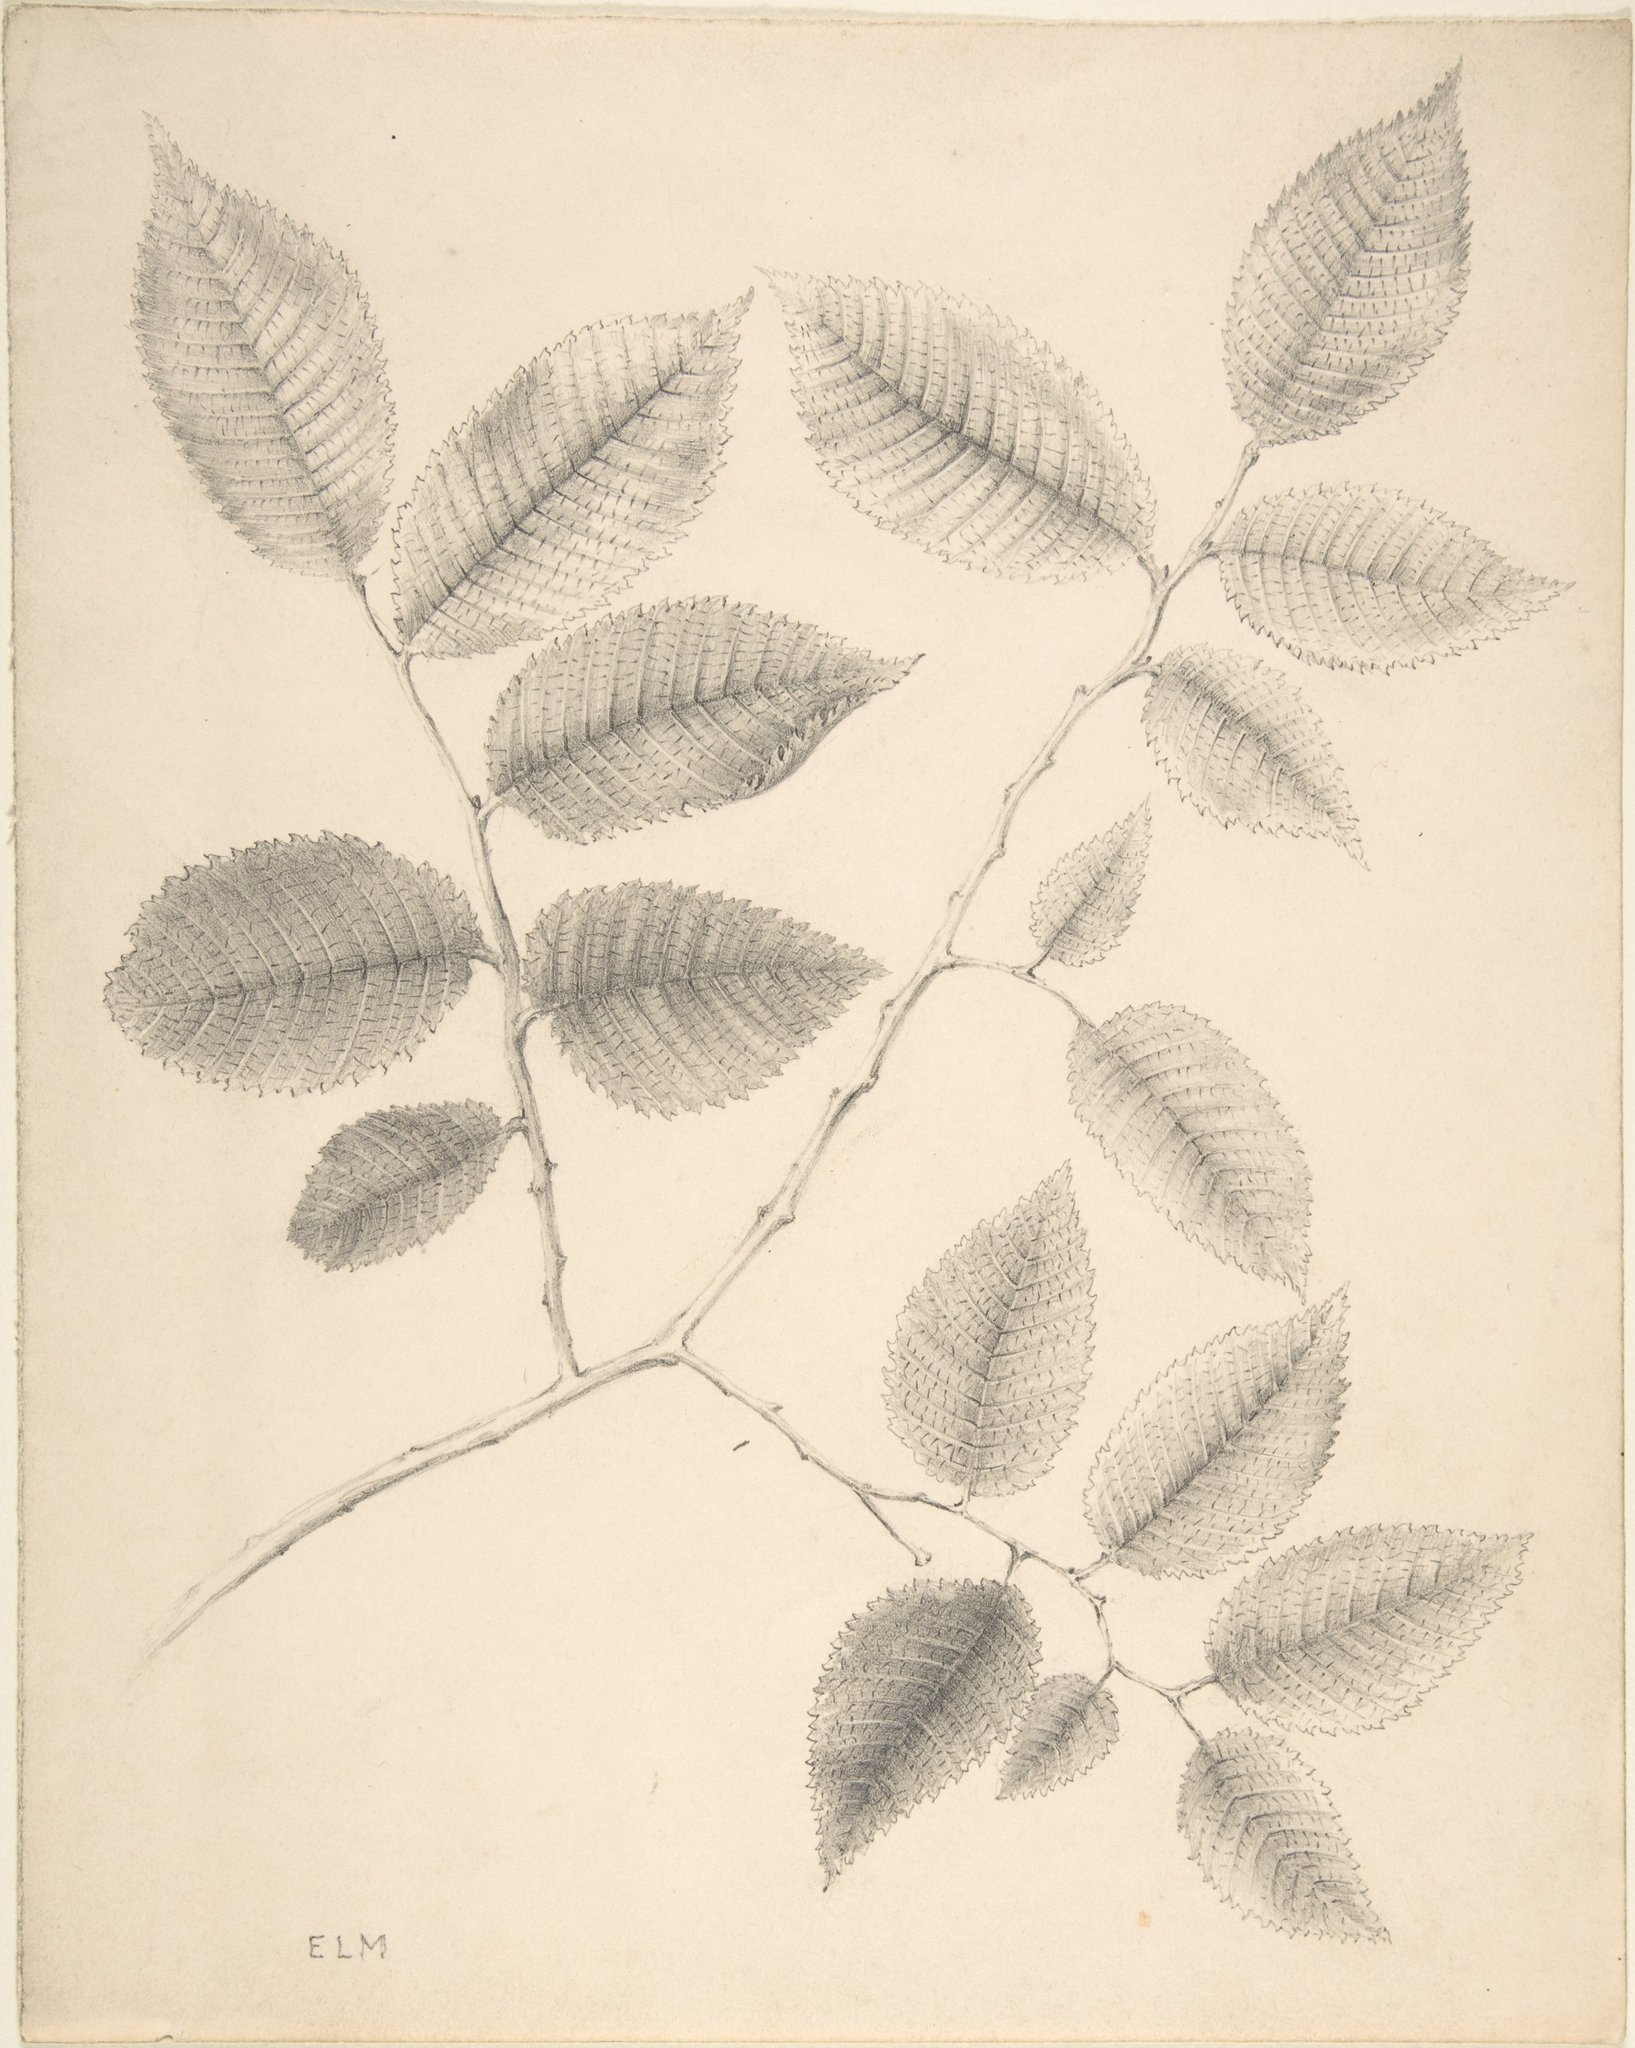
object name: drawing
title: Elm Leaves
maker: anonymous, british, 19th century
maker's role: artist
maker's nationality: british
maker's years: 1800-1900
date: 1801-1900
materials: graphite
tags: elms,leaves